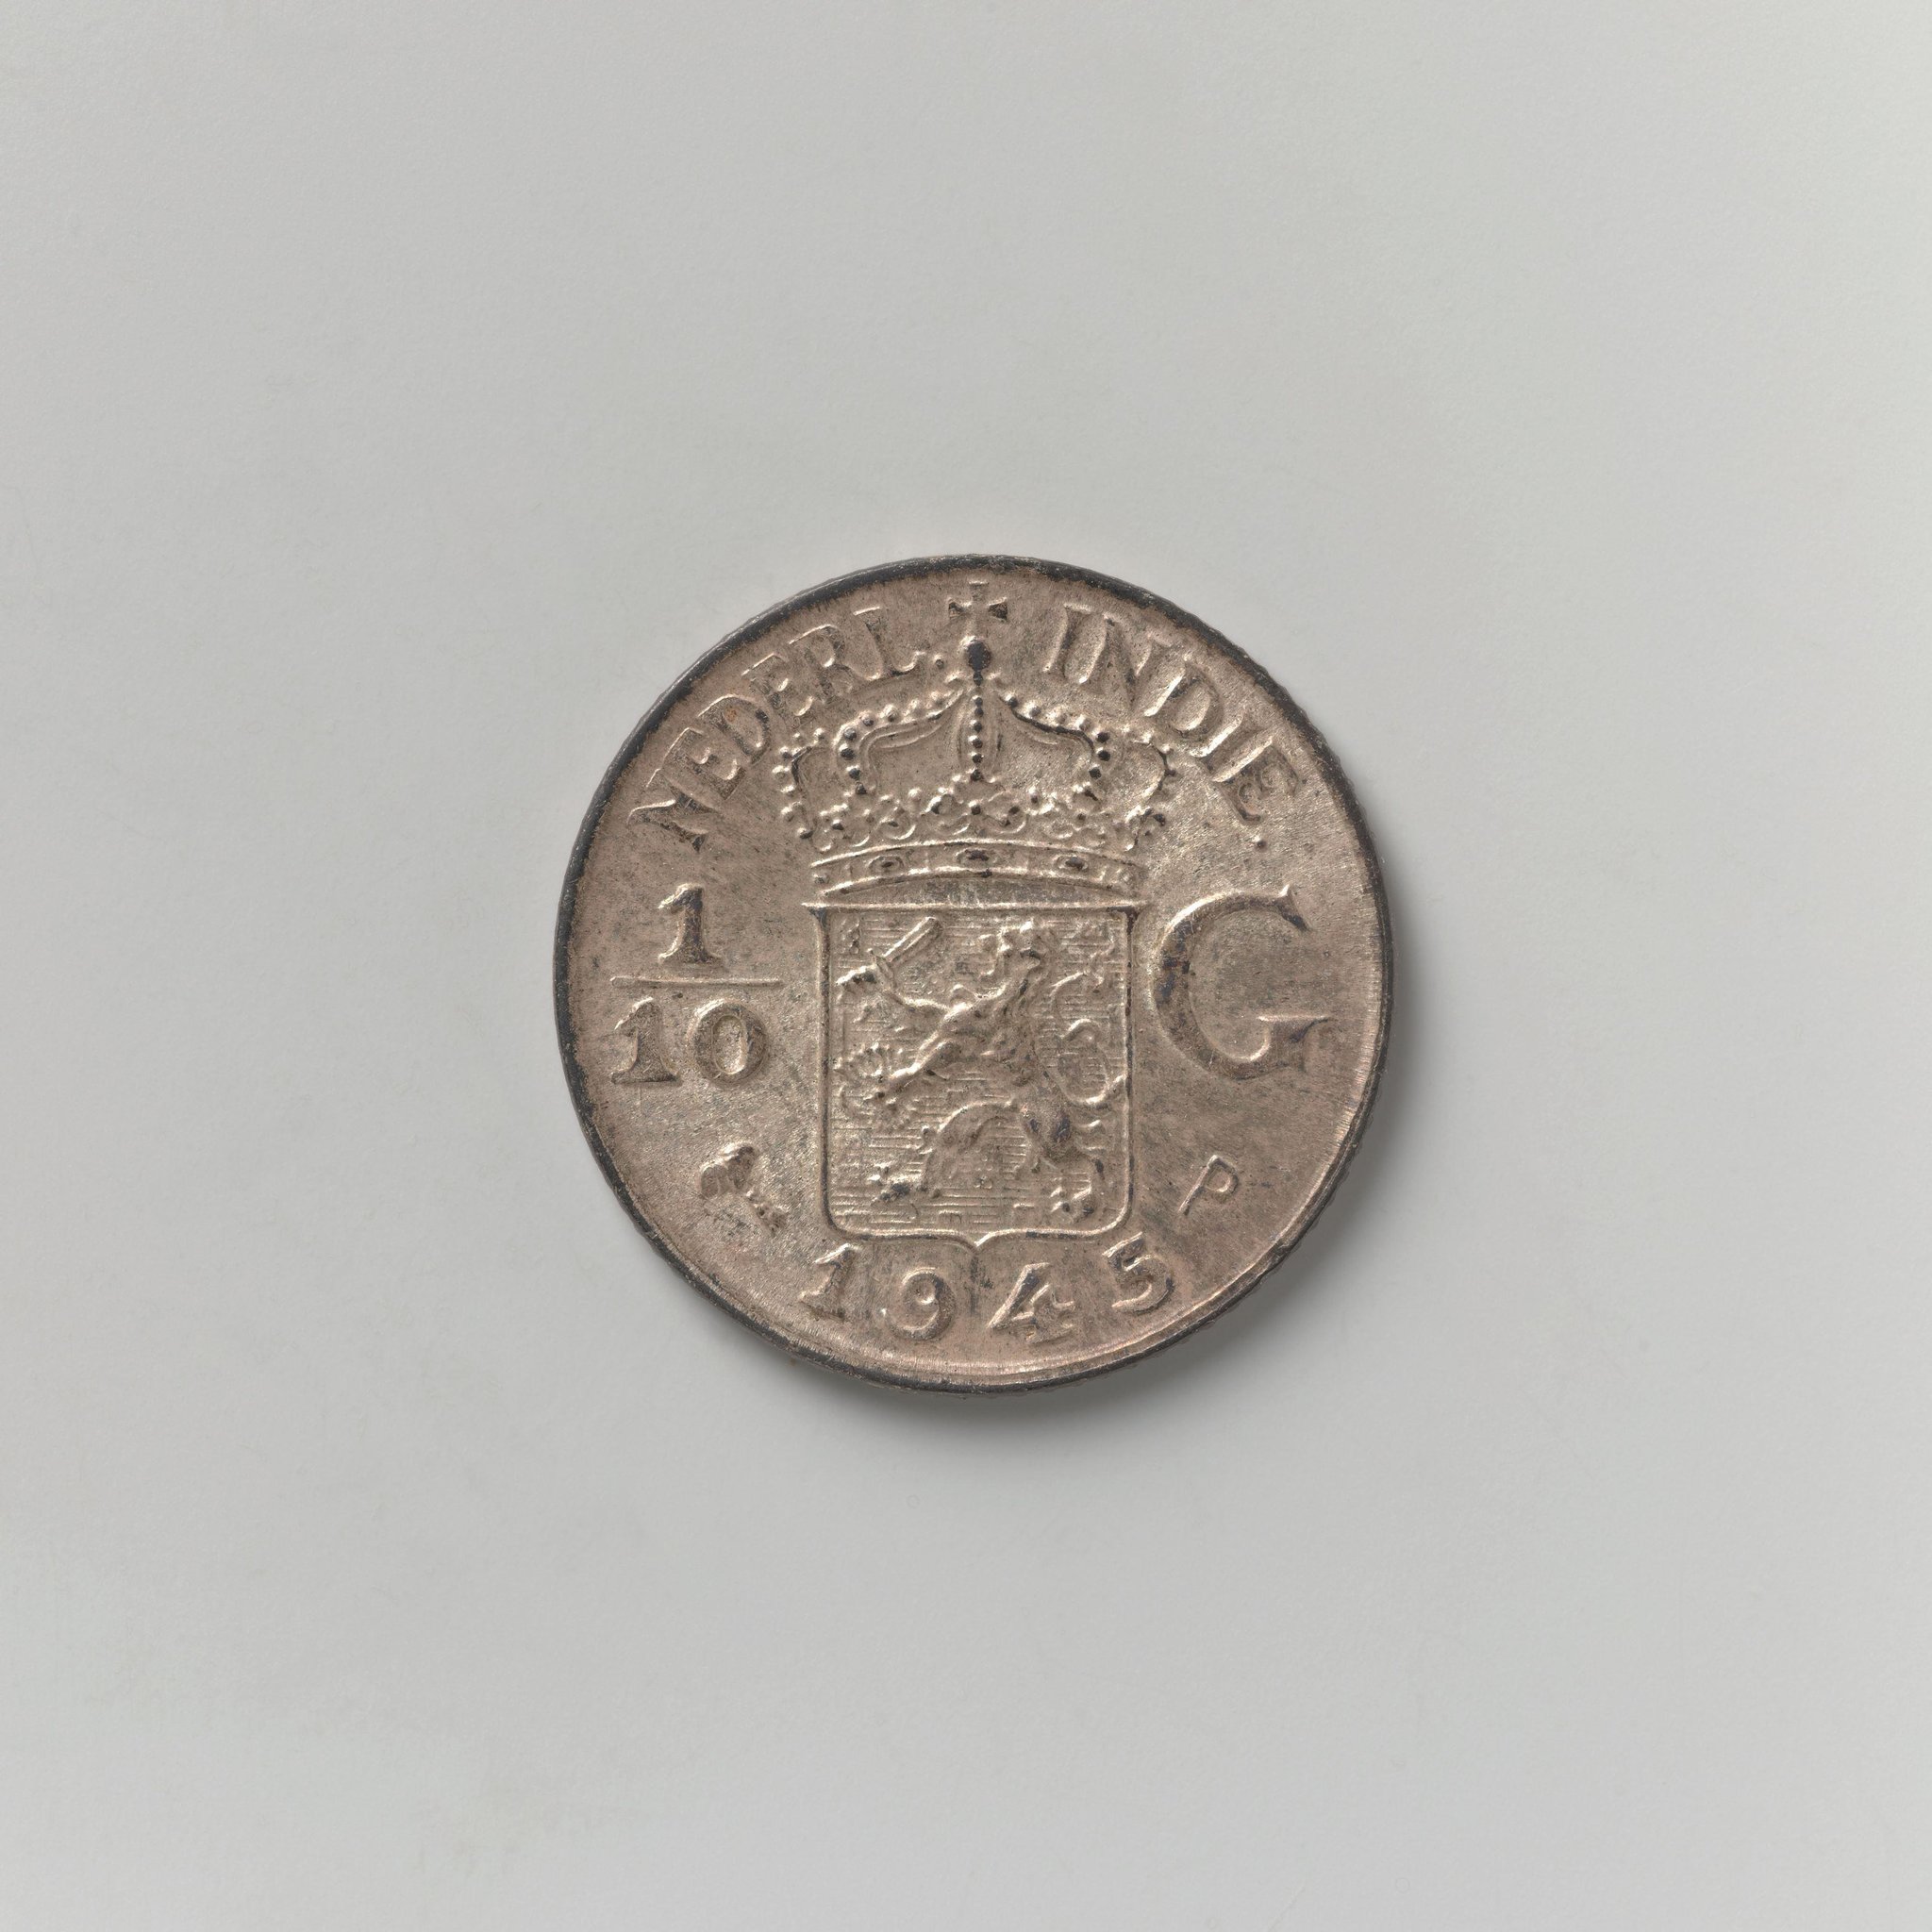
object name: coin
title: 1/10 gulden van Nederlands Indië,1945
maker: wilhelmina of the netherlands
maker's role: print maker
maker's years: 1880-1962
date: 1945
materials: copper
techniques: striking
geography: philadelphia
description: ilveren munt. Voorzijde: tussen waarde-aanduiding 1/10 G gekroond rijkswapenschild. Boven kroon landsaanduiding en onder wapenschild jaartal. Keerzijde: tweeregelig Maleis opschrift in Arabische tekens, waaromheen omschrift in het Javaans. Kartelrand.